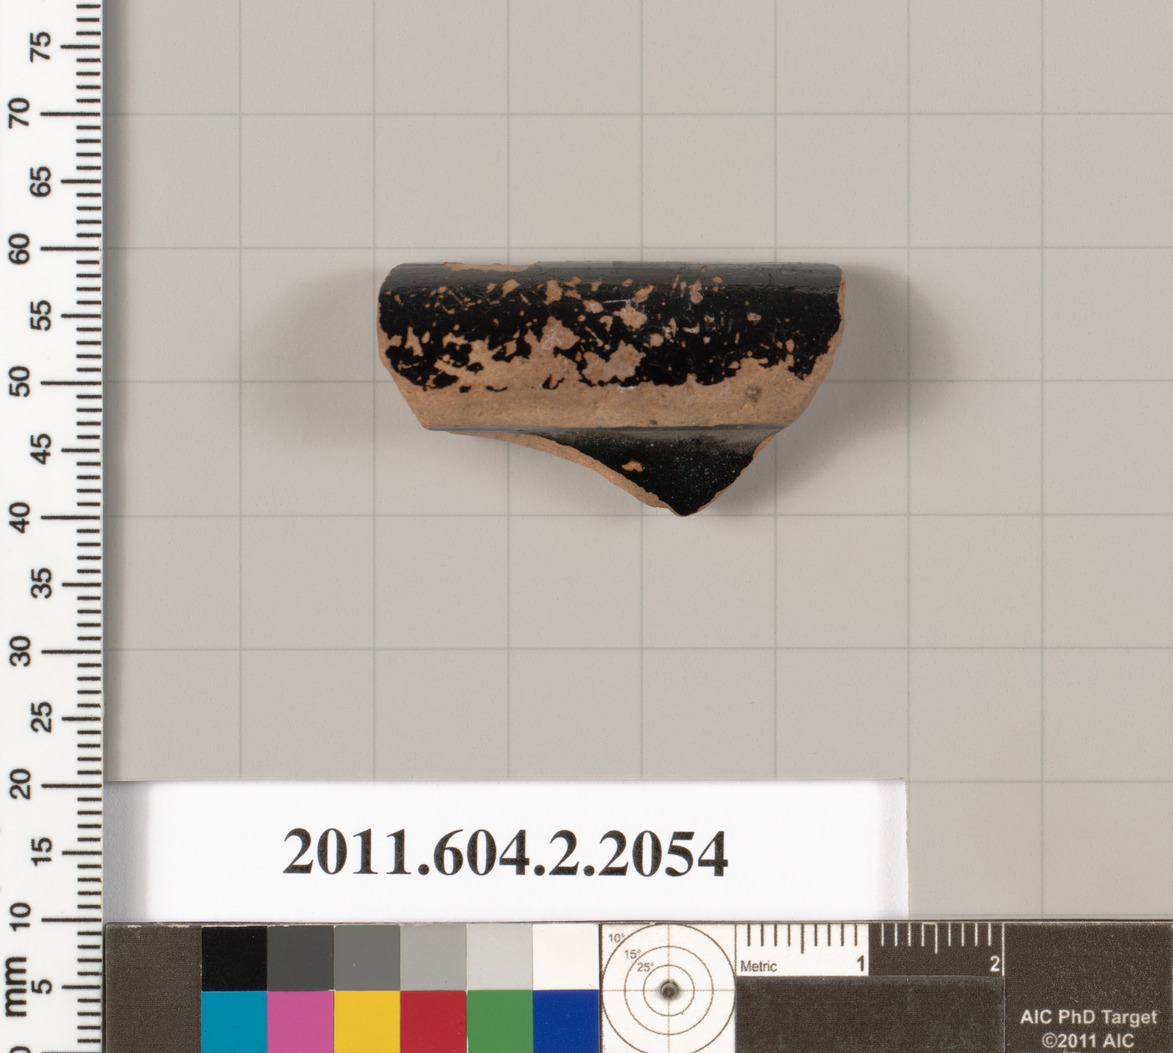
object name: pot fragment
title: Terracotta fragment of a pot; glazed on the inside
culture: greek, attic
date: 500-401 BCE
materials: terracotta